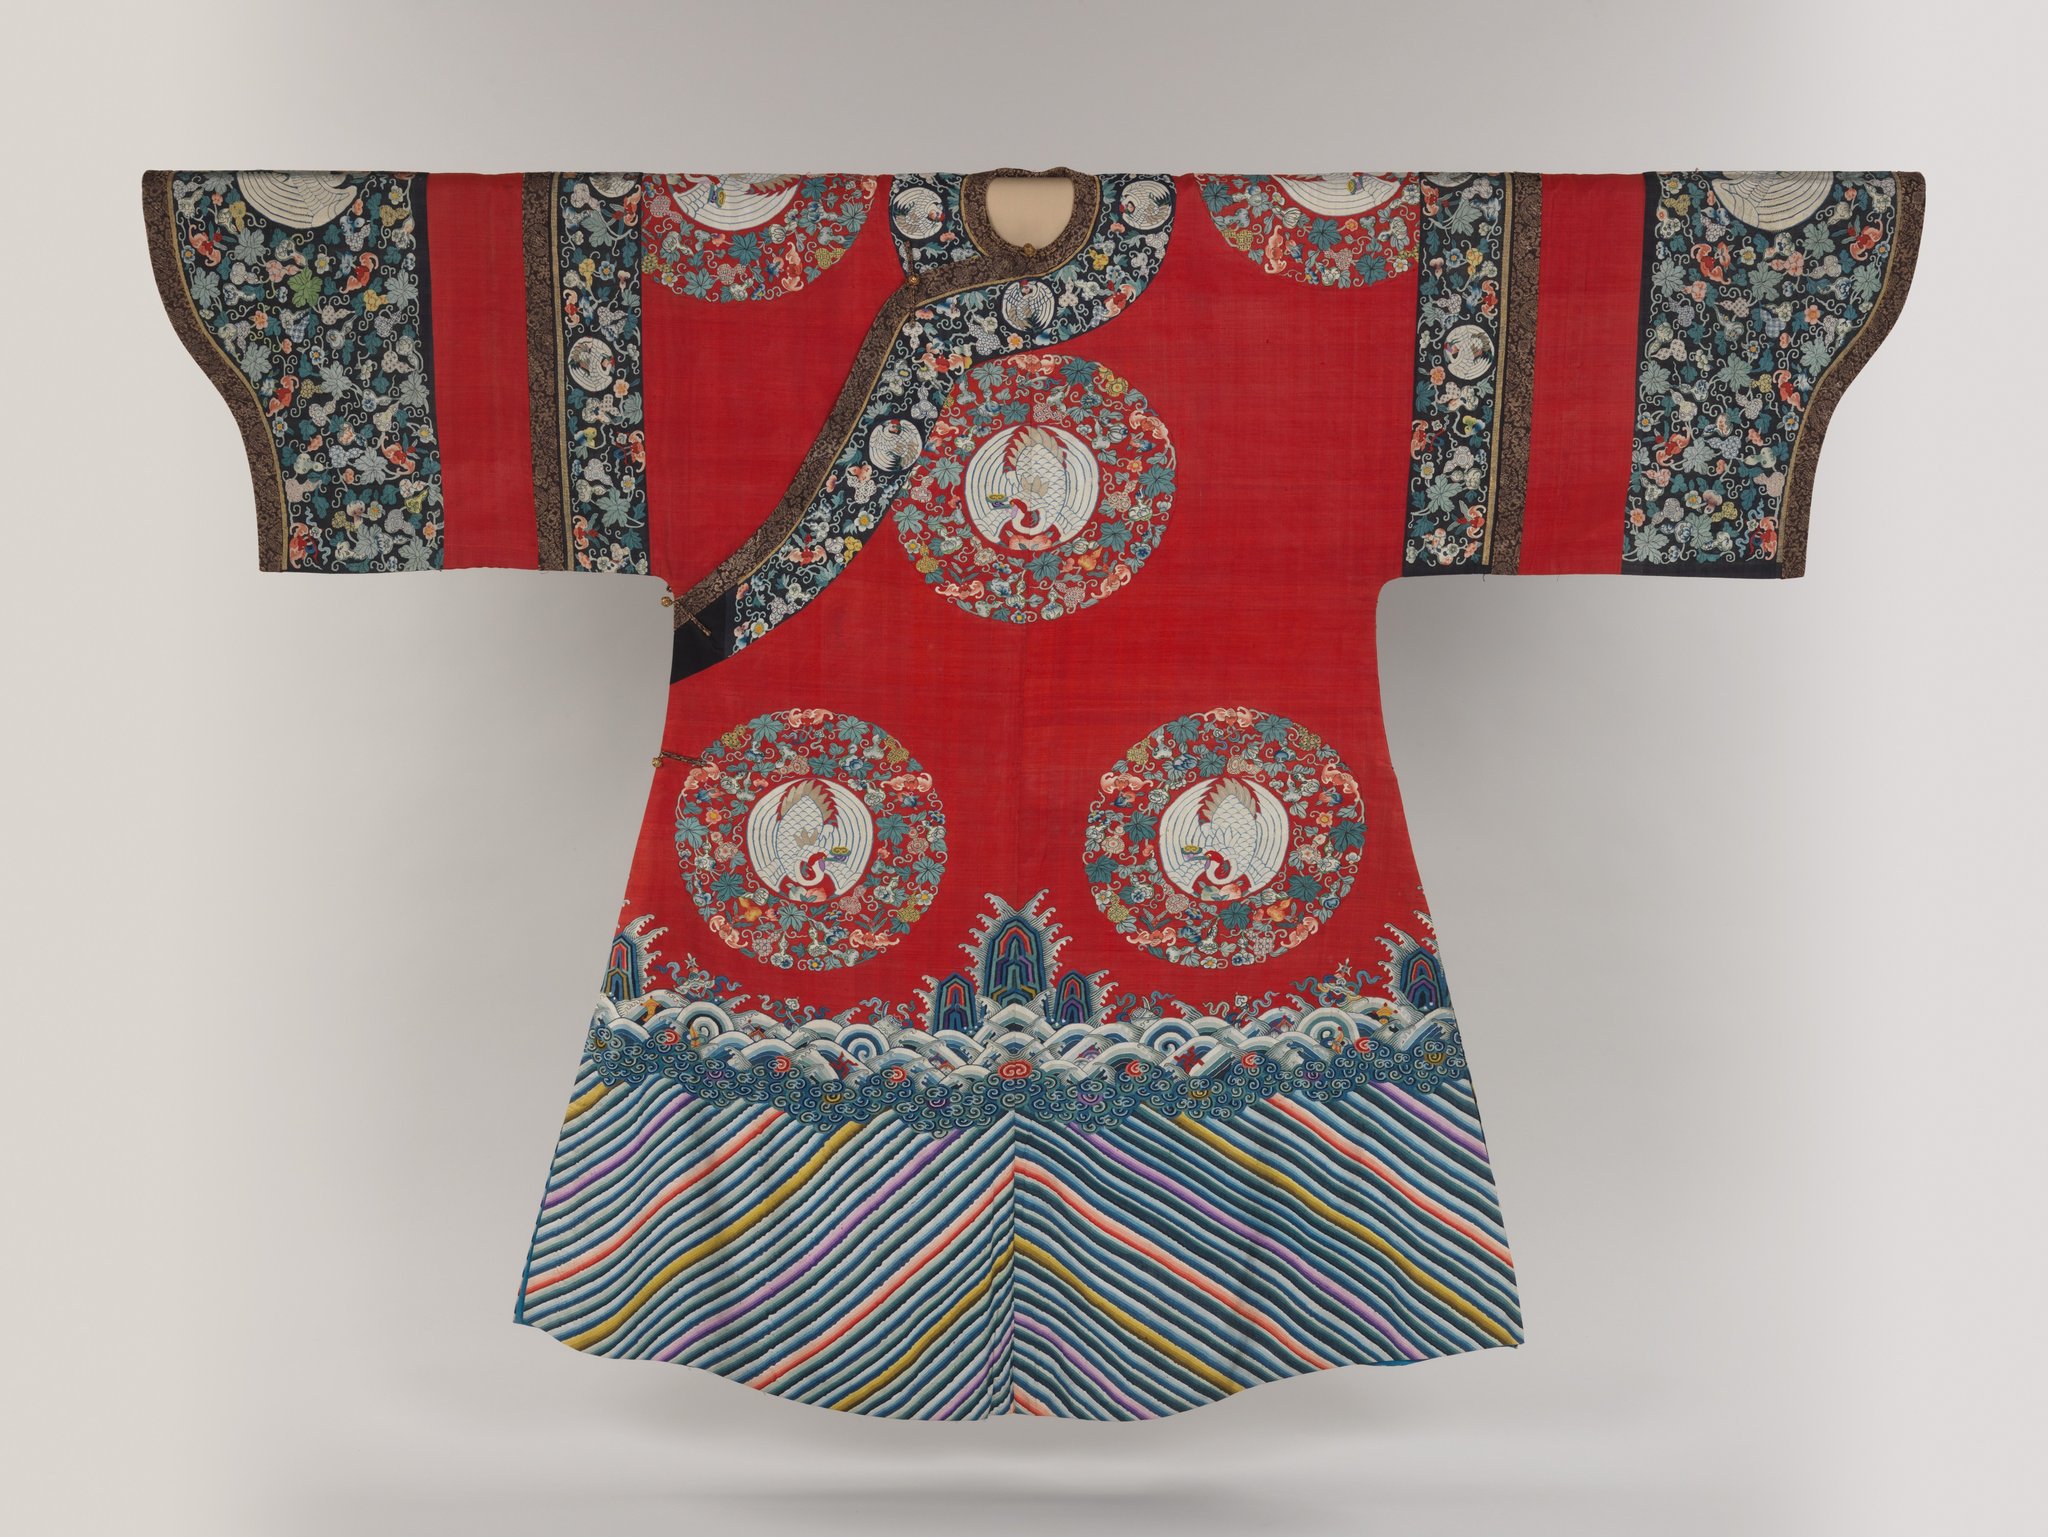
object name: robe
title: Woman’s robe decorated with crane medallions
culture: chinese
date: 1801-1900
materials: silk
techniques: tapestry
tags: cranes